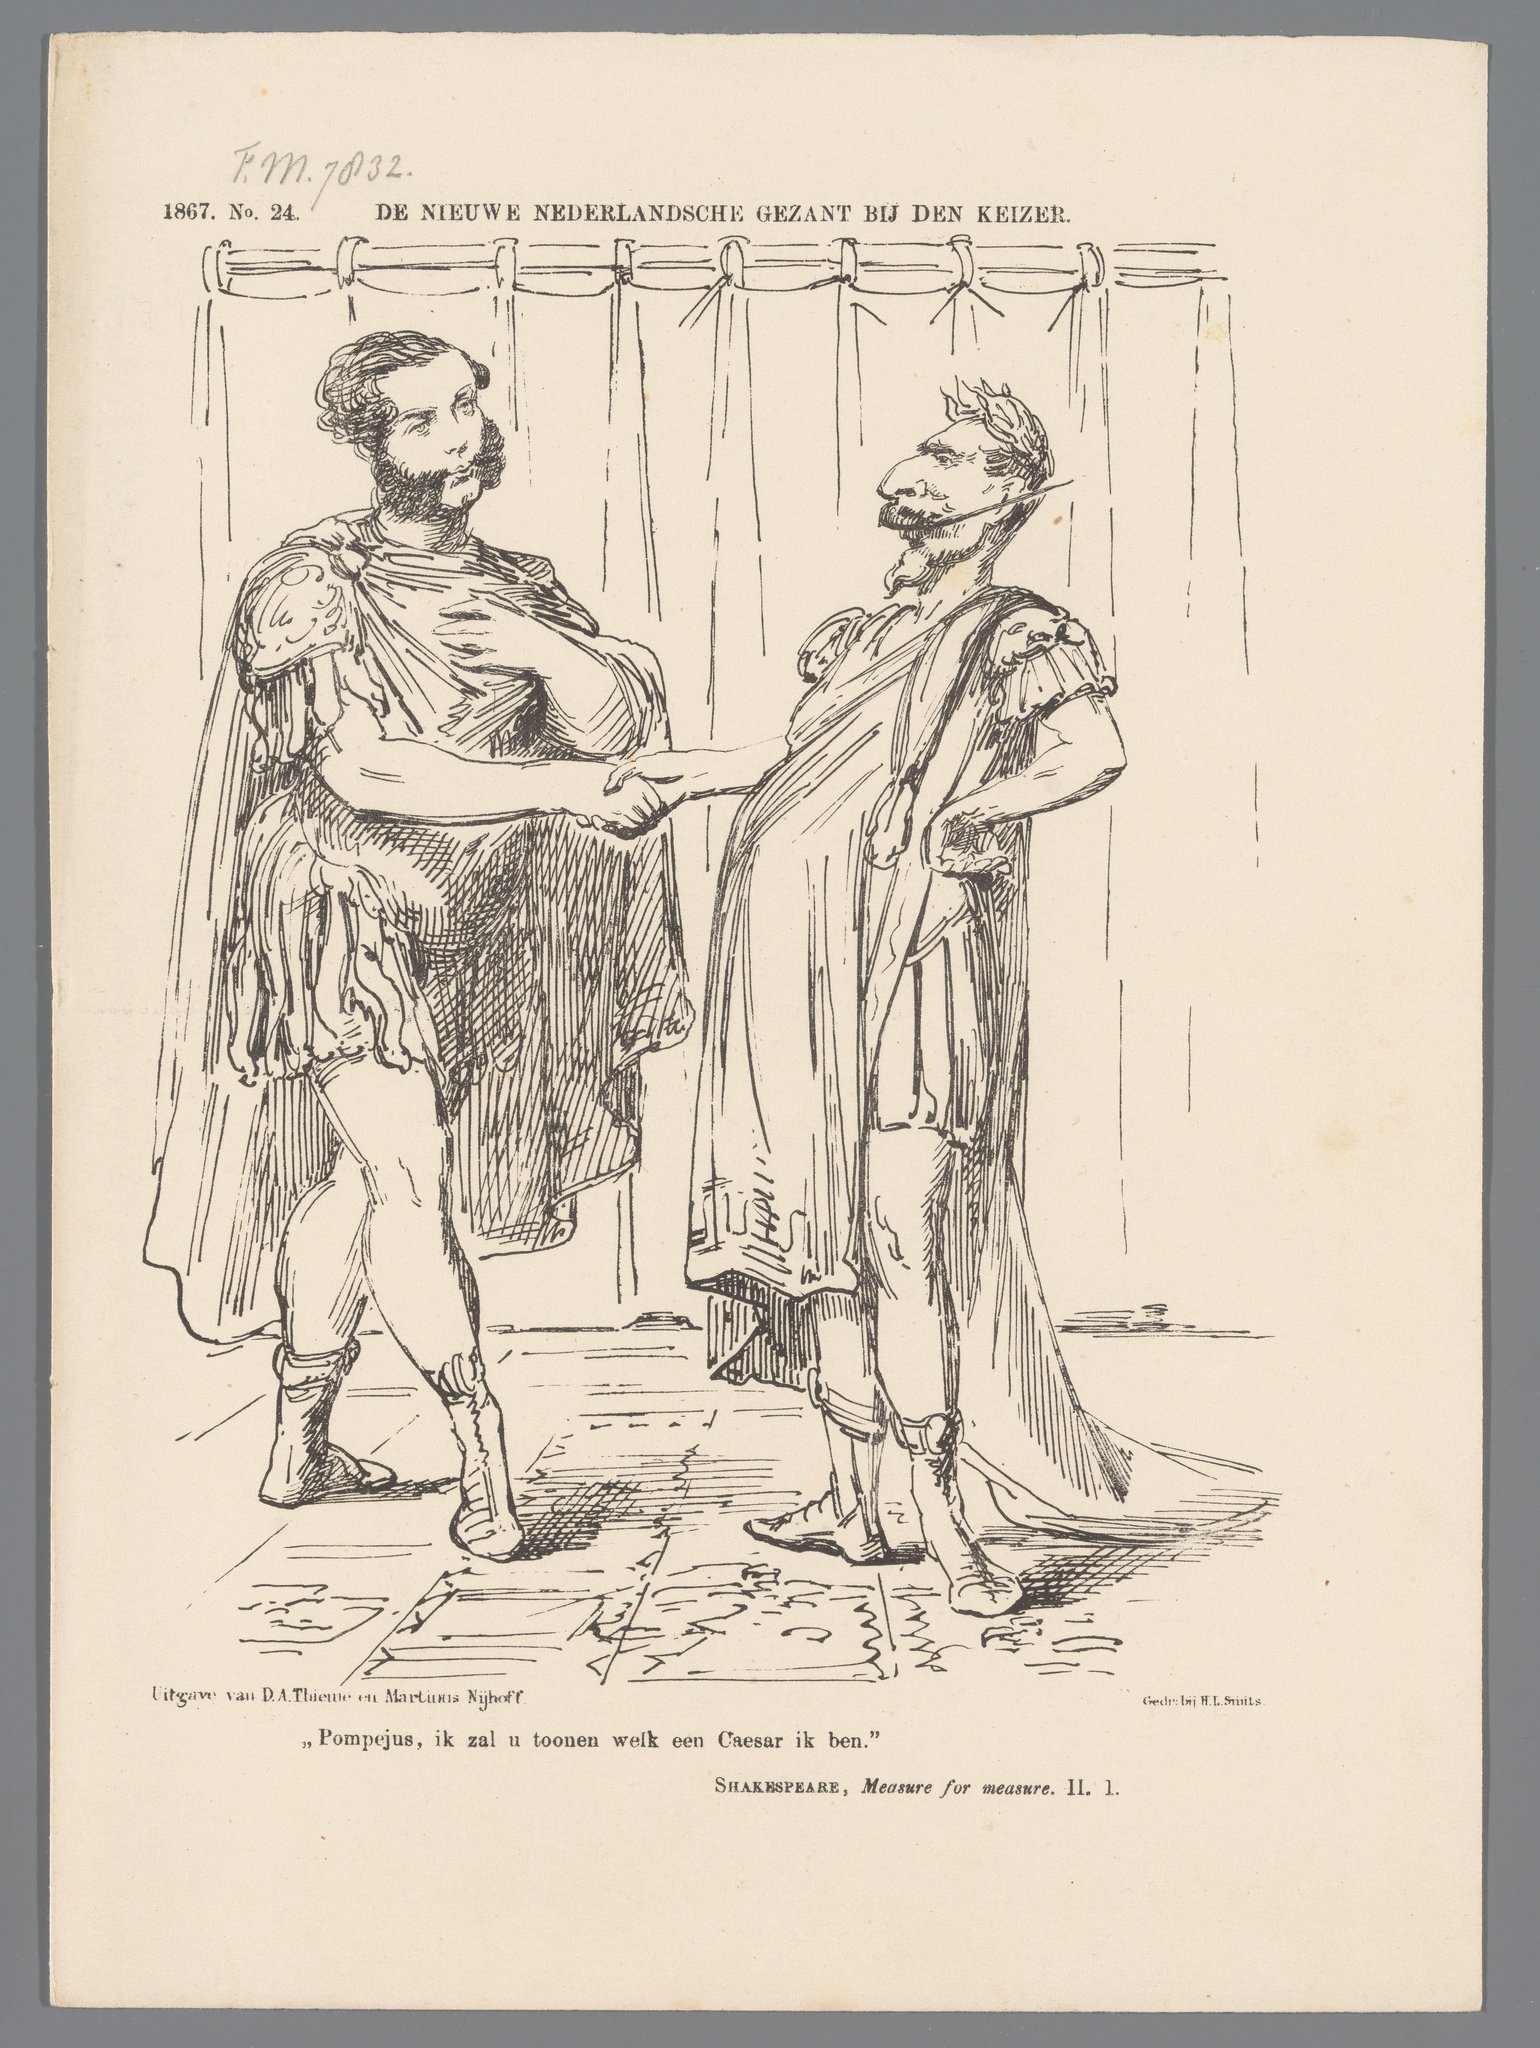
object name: cartoon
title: De nieuwe Nederlandsche gezant bij den keizer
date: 1867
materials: paper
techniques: lithograph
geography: netherlands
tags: paris, london, napoleon iii (keizer der fransen)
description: Spotprent met de ontmoeting tussen de Nederlandse gezant Van Zuylen en de Franse keizer Napoleon III, beiden als Romeinen. Plaat verschenen bij het weekblad De Nederlandsche Spectator, nr. 24, 15 juni 1867.